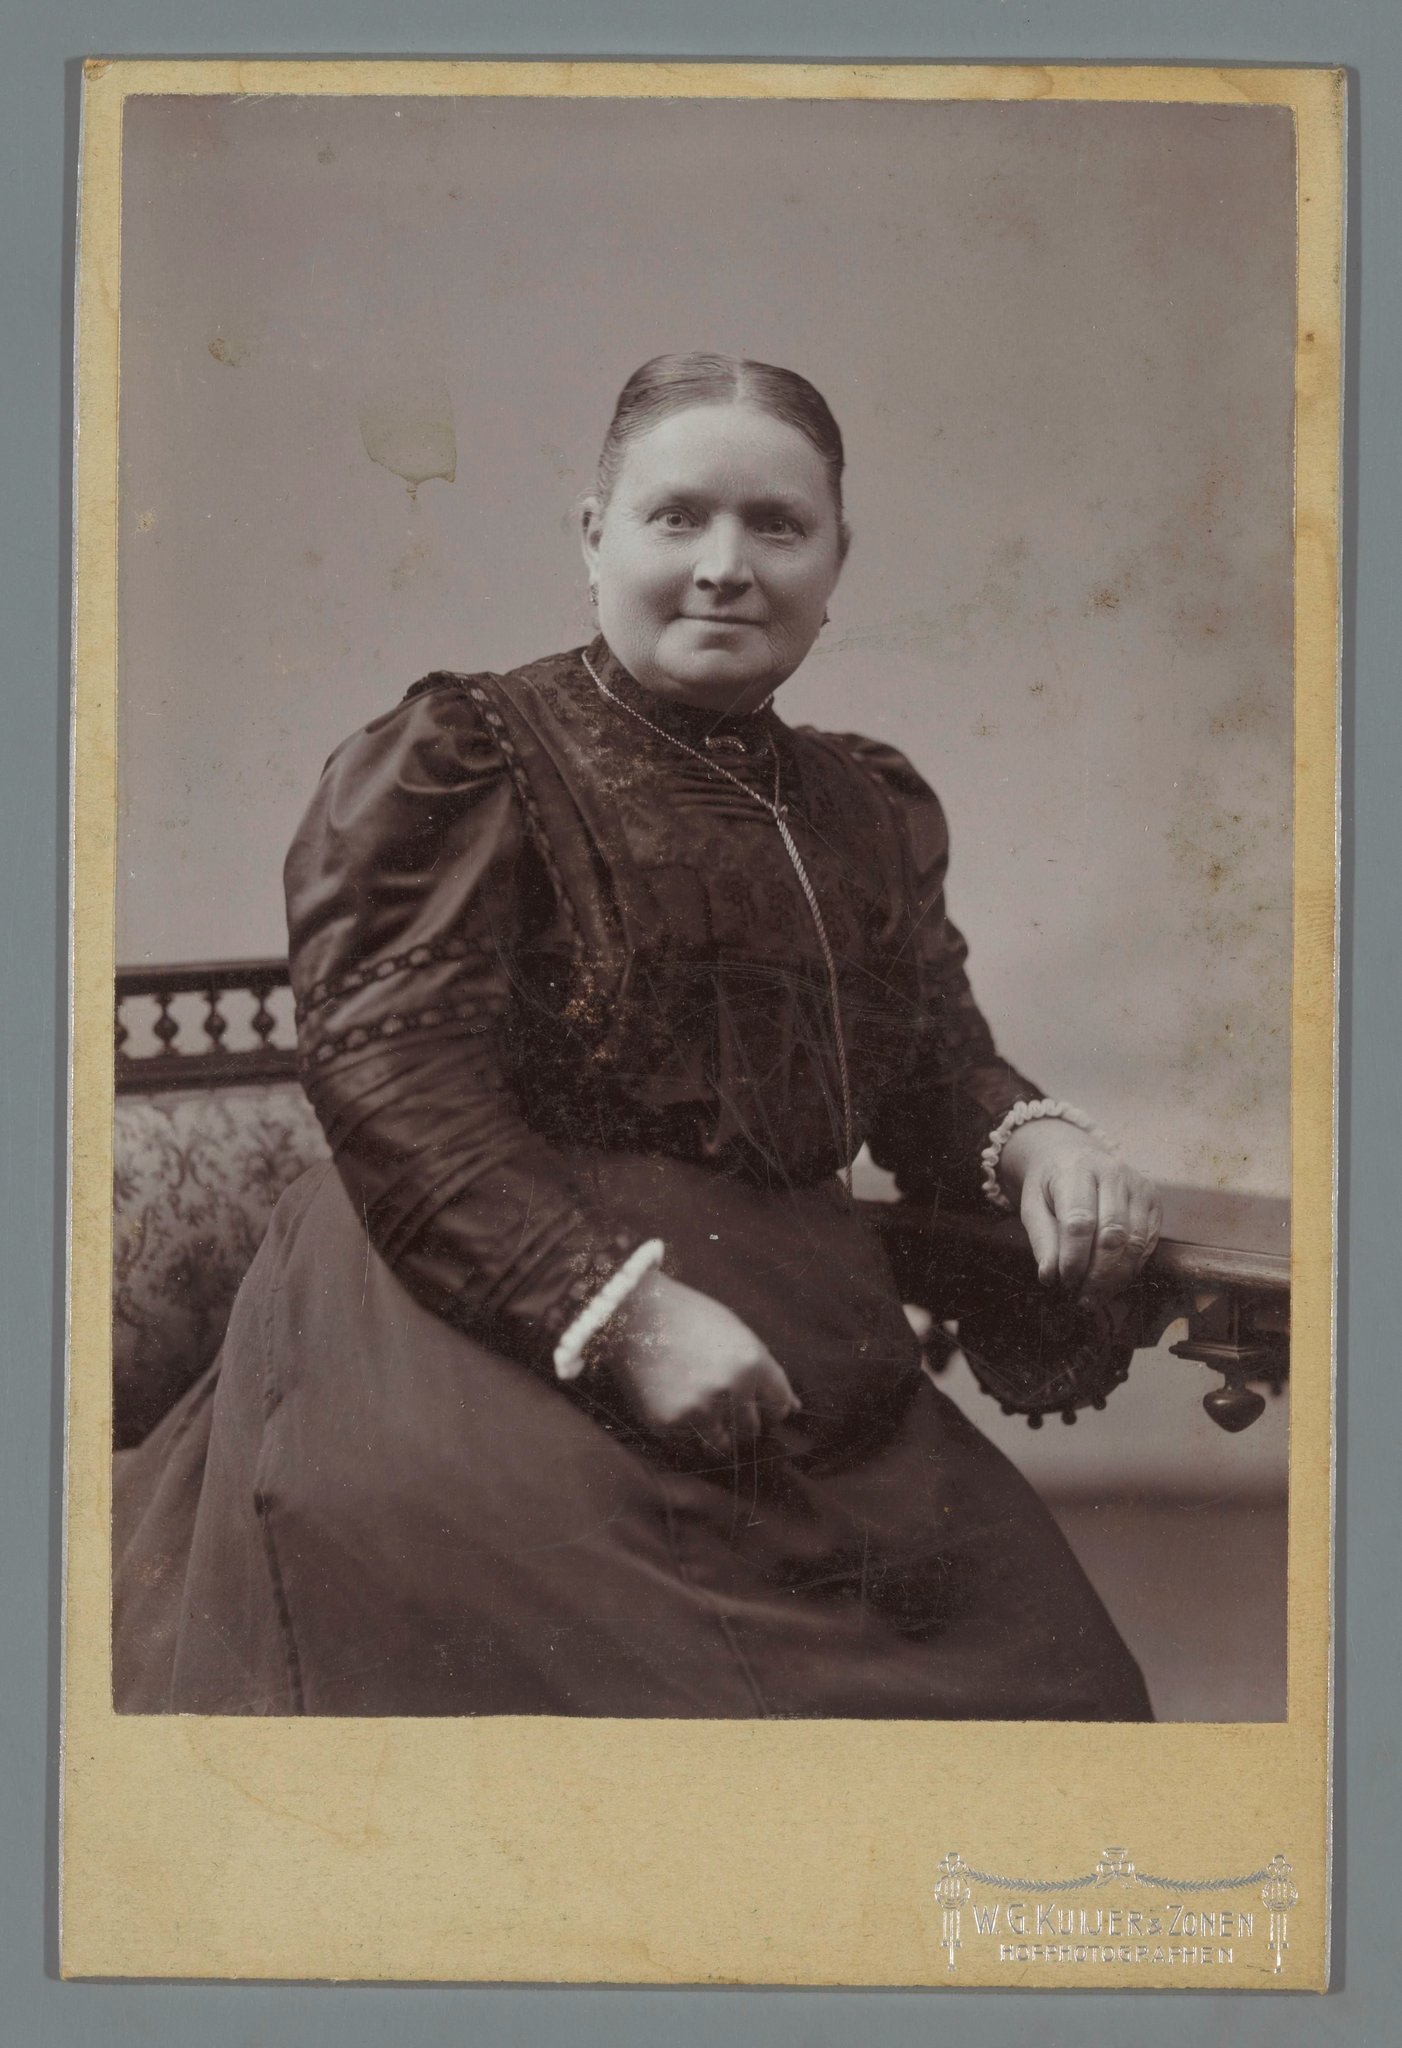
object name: cabinet photograph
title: Portret van een onbekende vrouw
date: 1885-1906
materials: cardboard, photographic support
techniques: collodion silver print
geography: amsterdam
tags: adult woman, studio requisites ~ photographer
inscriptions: name: ‘W.G. Kuijer & Zonen Hofphotographen Amsterdam Westermarkt 19. (...)’